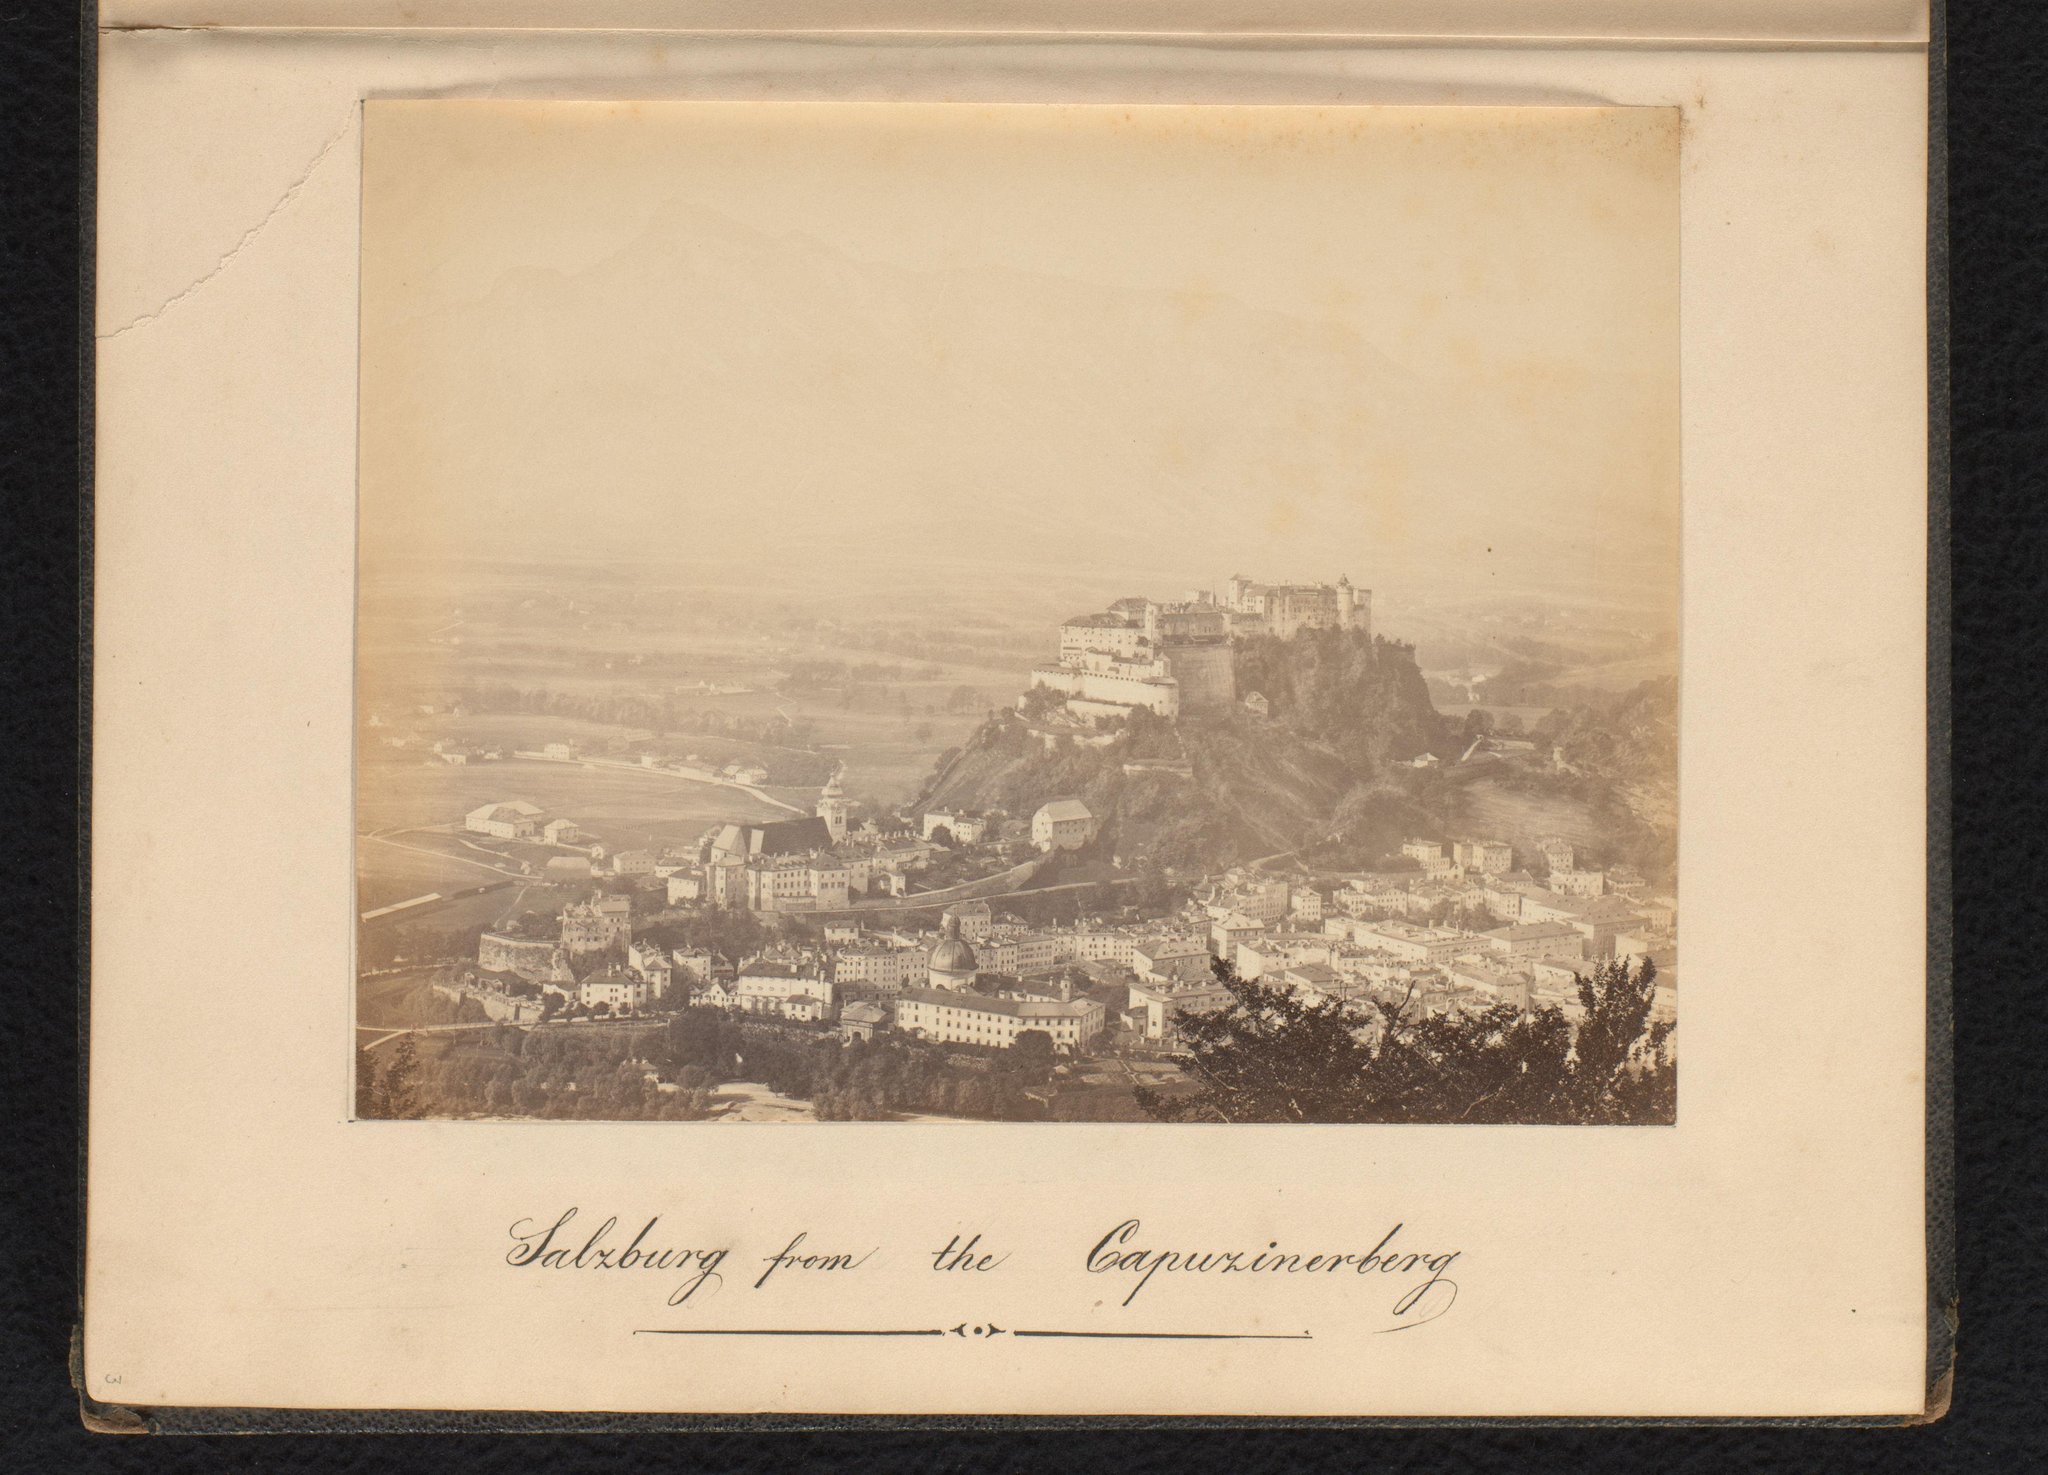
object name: photograph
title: Gezicht op Salzburg en de burcht Hohensalzburg, gezien vanaf de Kapuzinerberg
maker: Anonymous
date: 1860-1870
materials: paper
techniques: albumen print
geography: salzburg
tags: city-view in general; 'veduta', castle